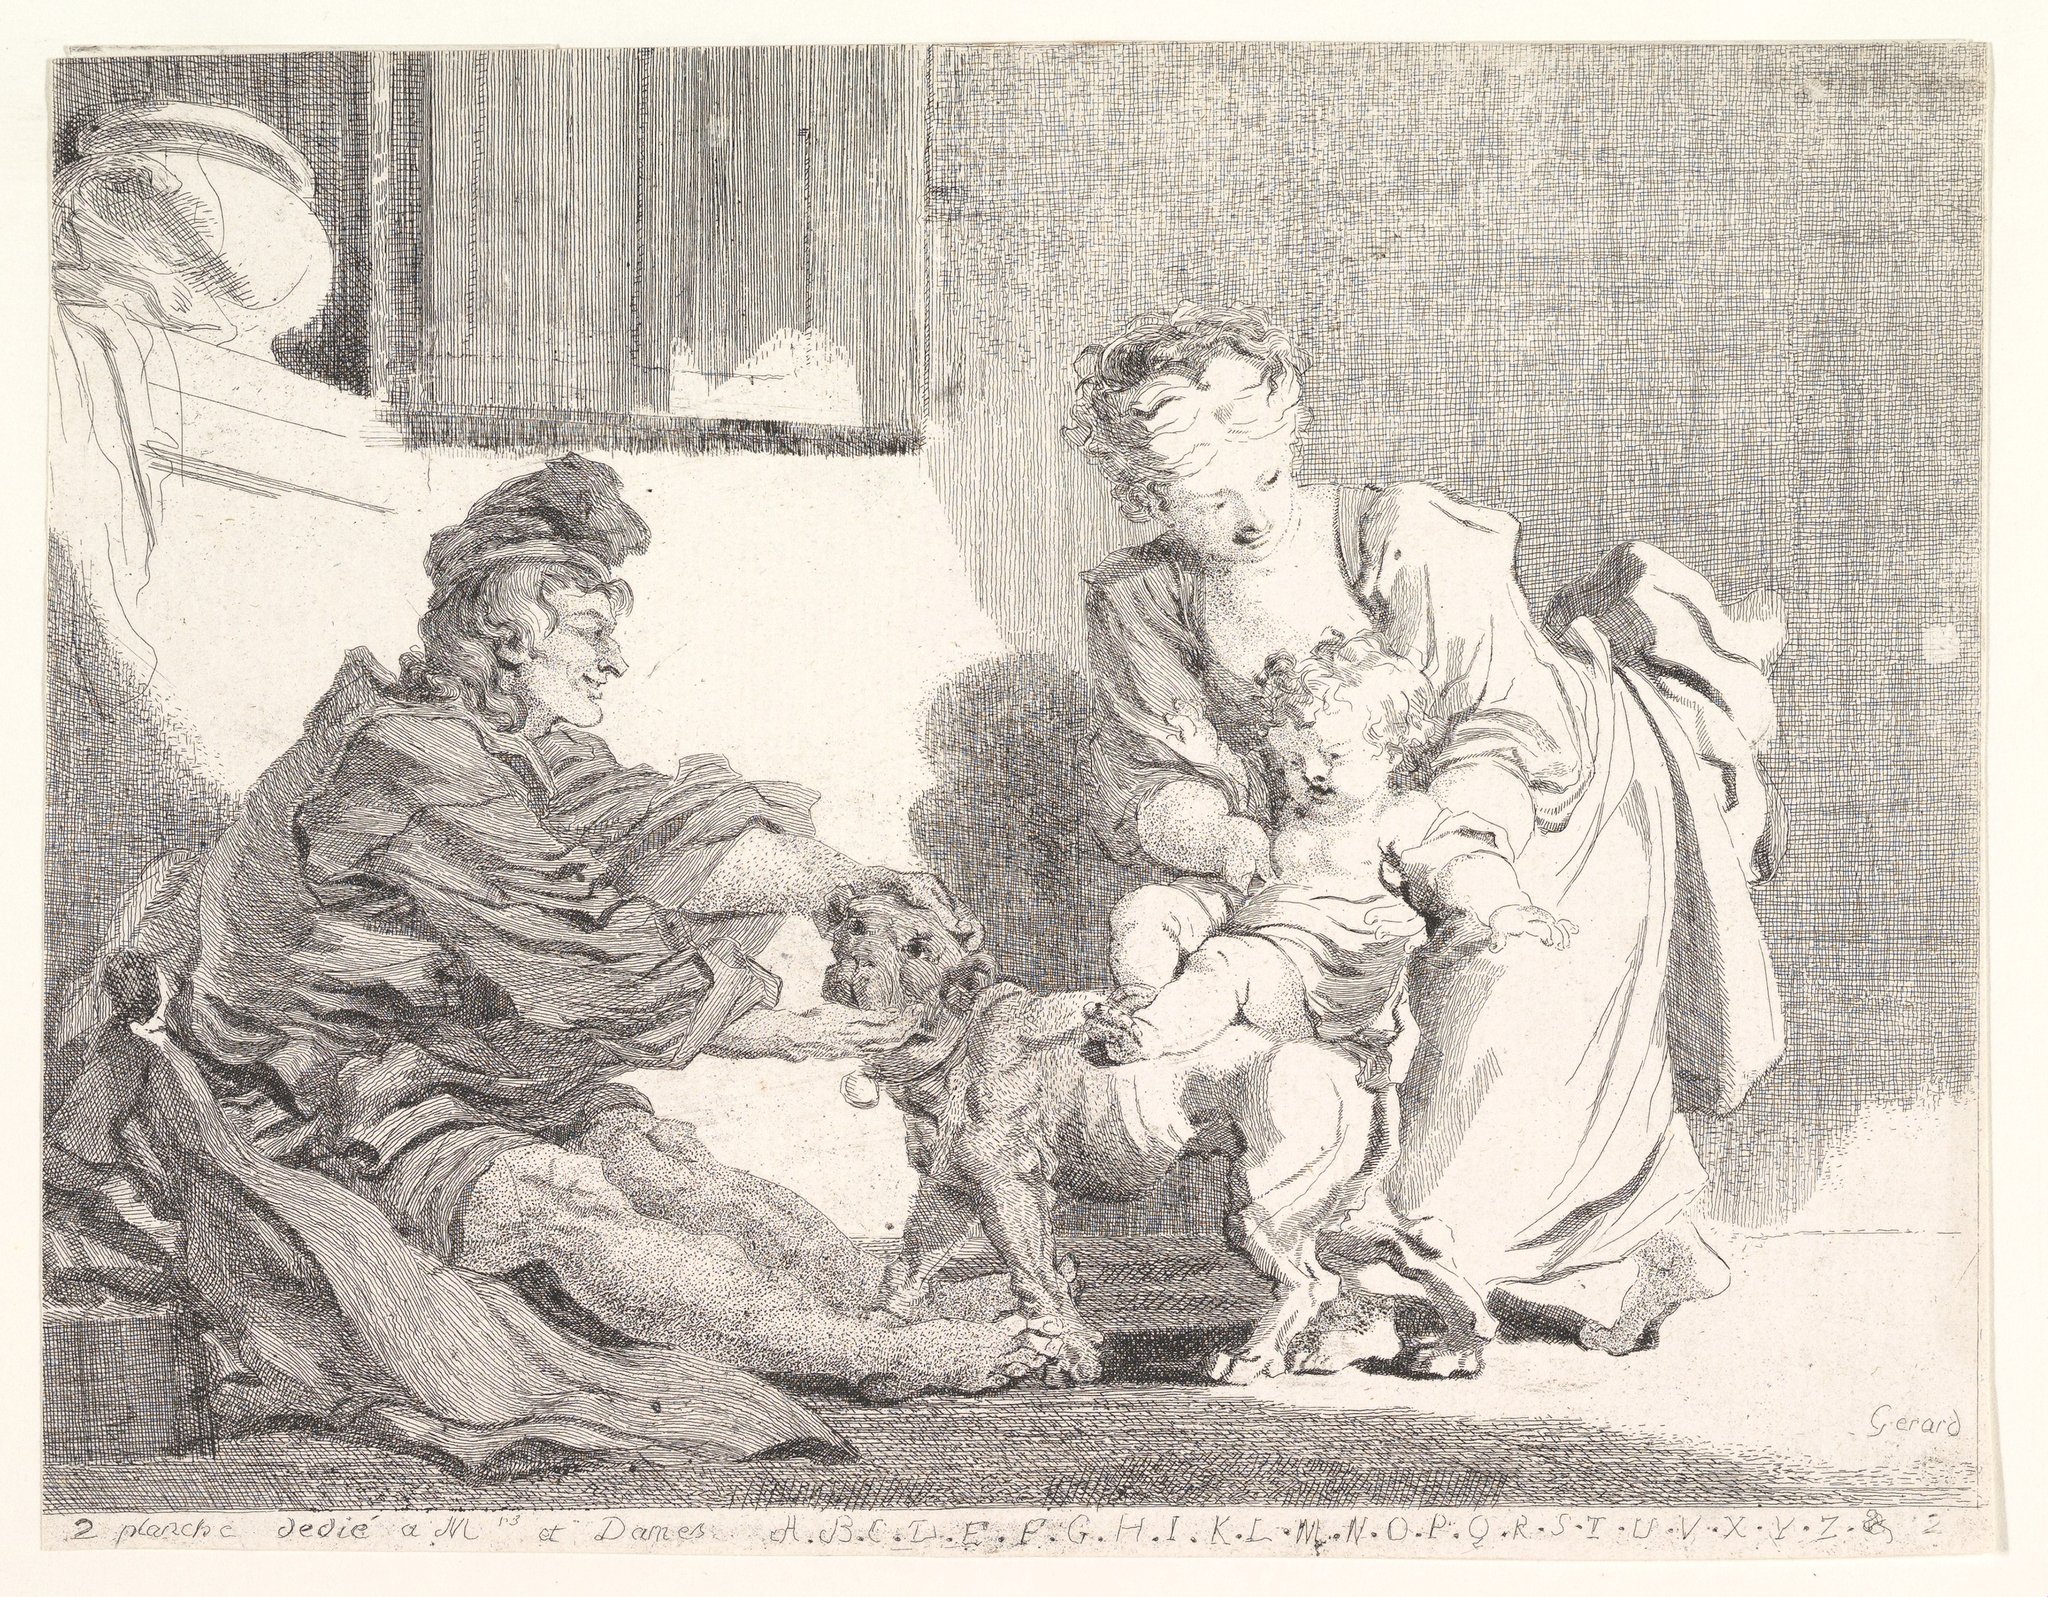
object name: print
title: The Child and the Bulldog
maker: marguerite gérard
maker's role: artist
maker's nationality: french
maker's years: 1761-1837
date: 1778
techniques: etching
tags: children,men,women,dogs